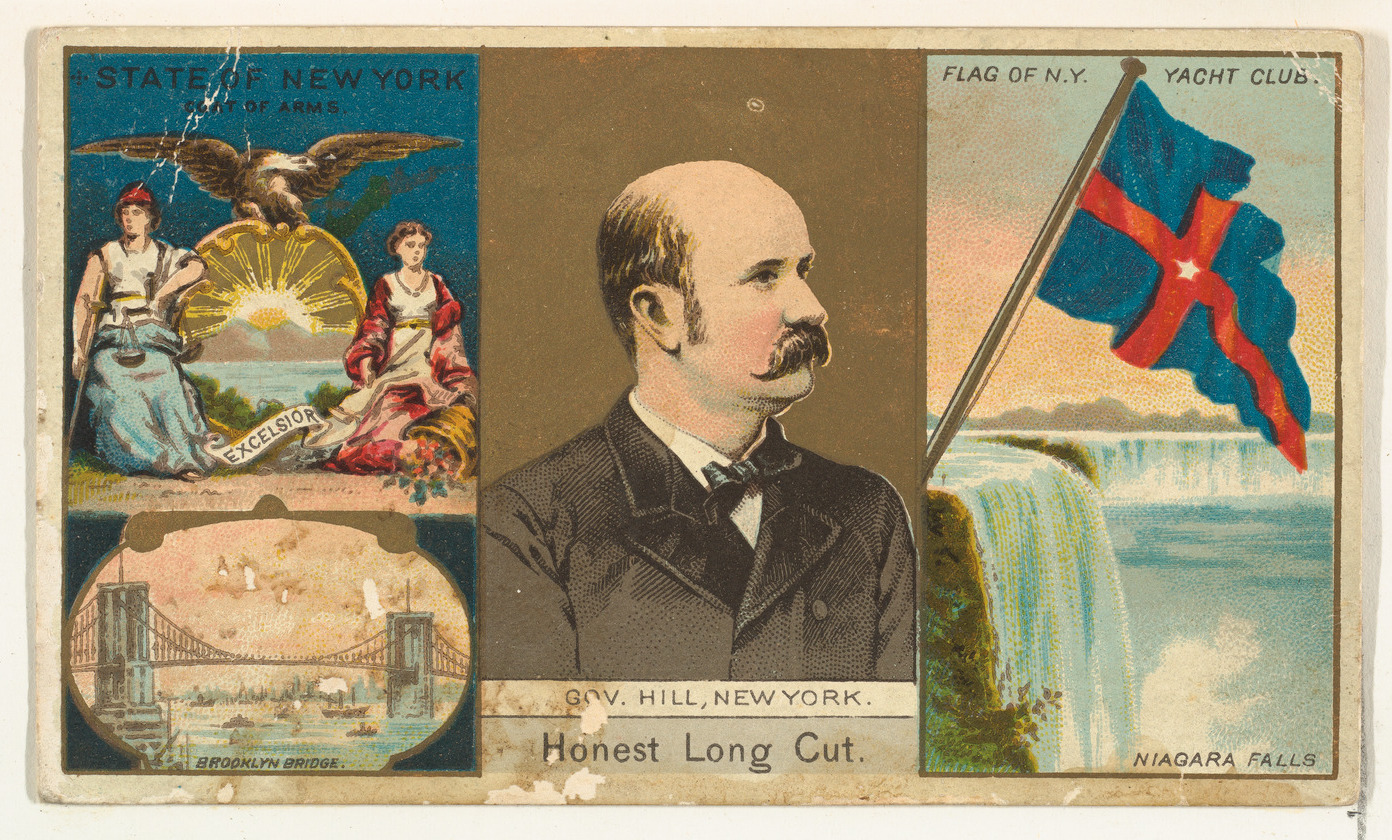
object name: print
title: Governor Hill, New York, from "Governors, Arms, Etc." series (N133-1), issued by Duke Sons & Co.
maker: w. duke, sons & co.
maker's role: publisher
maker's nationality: american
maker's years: 1870-1920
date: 1888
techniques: color lithograph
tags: birds,bridges,men,profiles,coat of arms